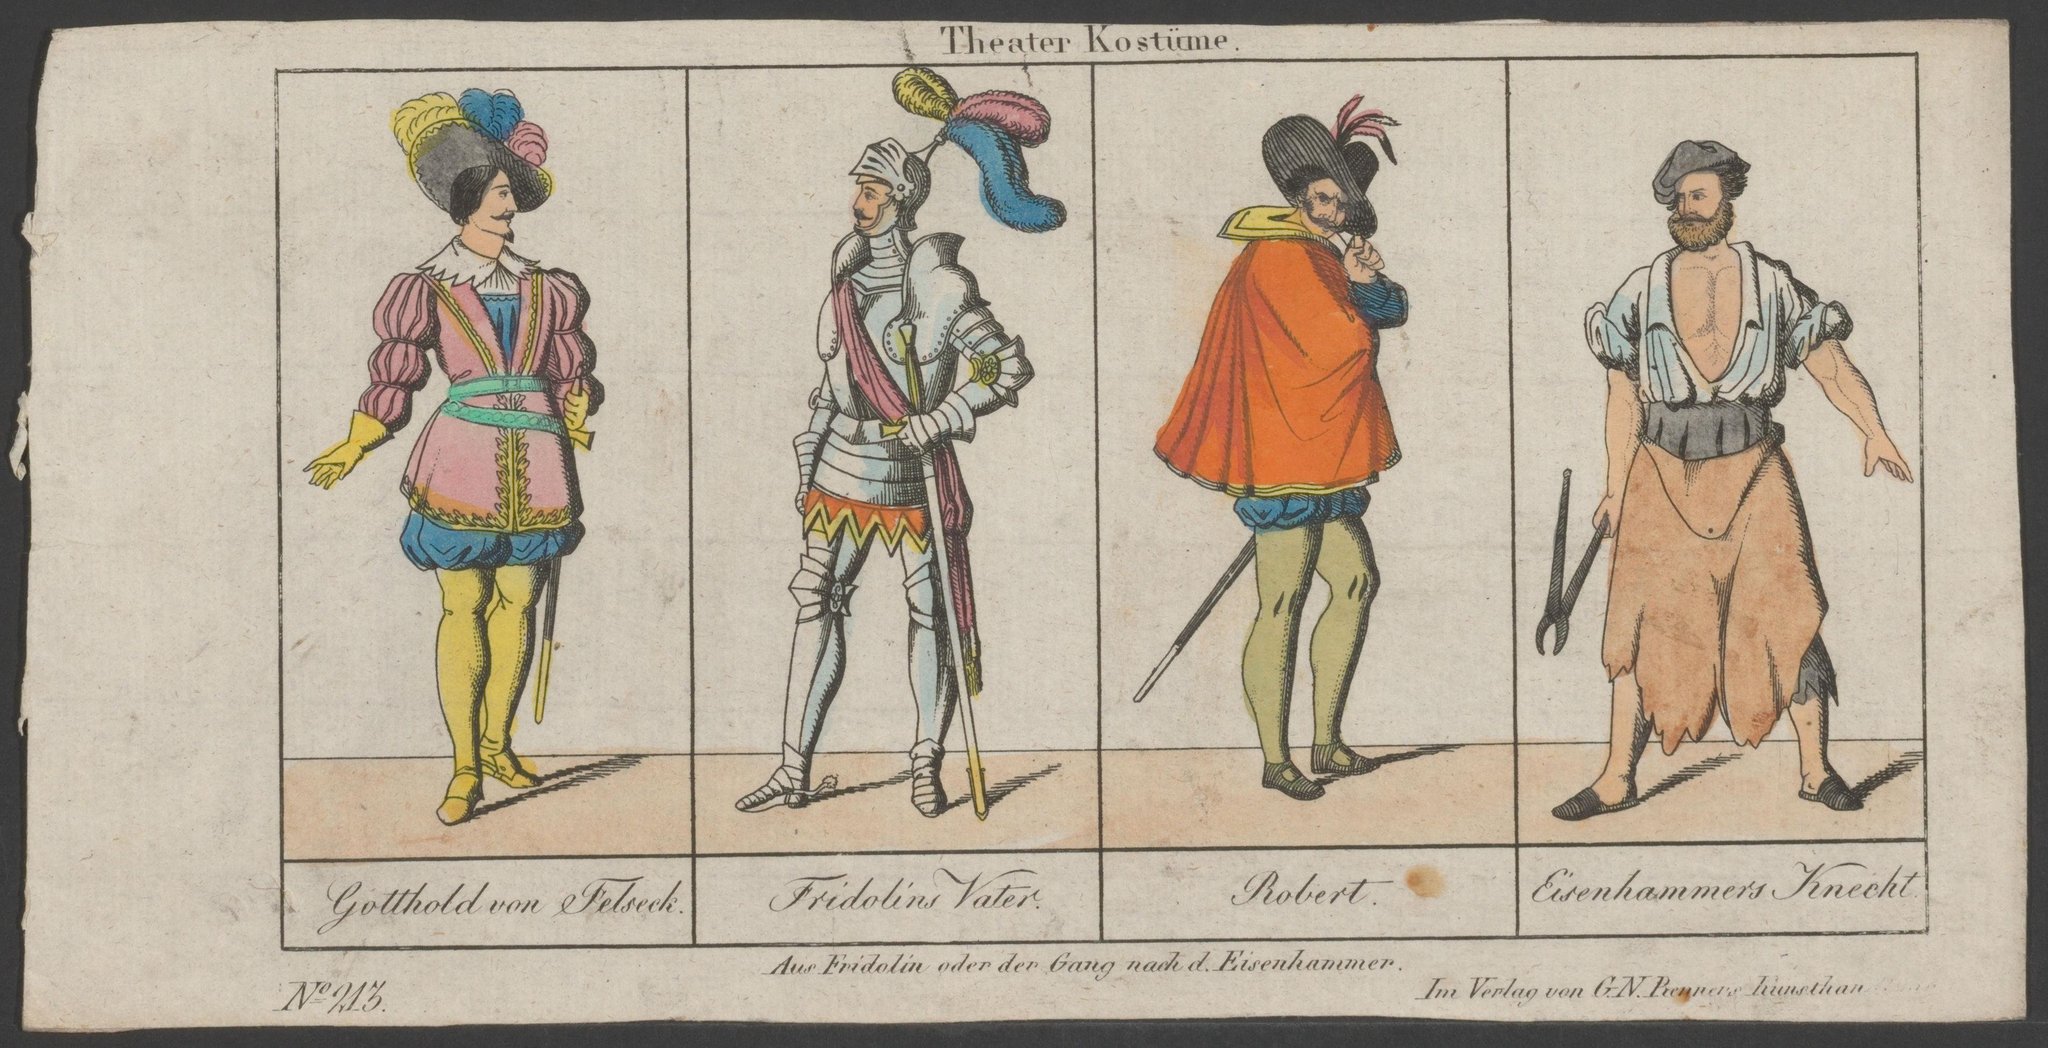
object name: print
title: Theater Kostüme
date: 1815-1858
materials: paper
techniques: etching, hand coloring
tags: stage costume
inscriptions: collector's mark: Lugt 1641, stamp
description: Linksonder genummerd: No. 213. Onderwerpsrubrieken binnen de Atlas Zeden en Gewoonten: Zeden en gewoonten in engeren zin, Des menschen begin, midden en einde, Kinderprenten opgeplakt op karton.